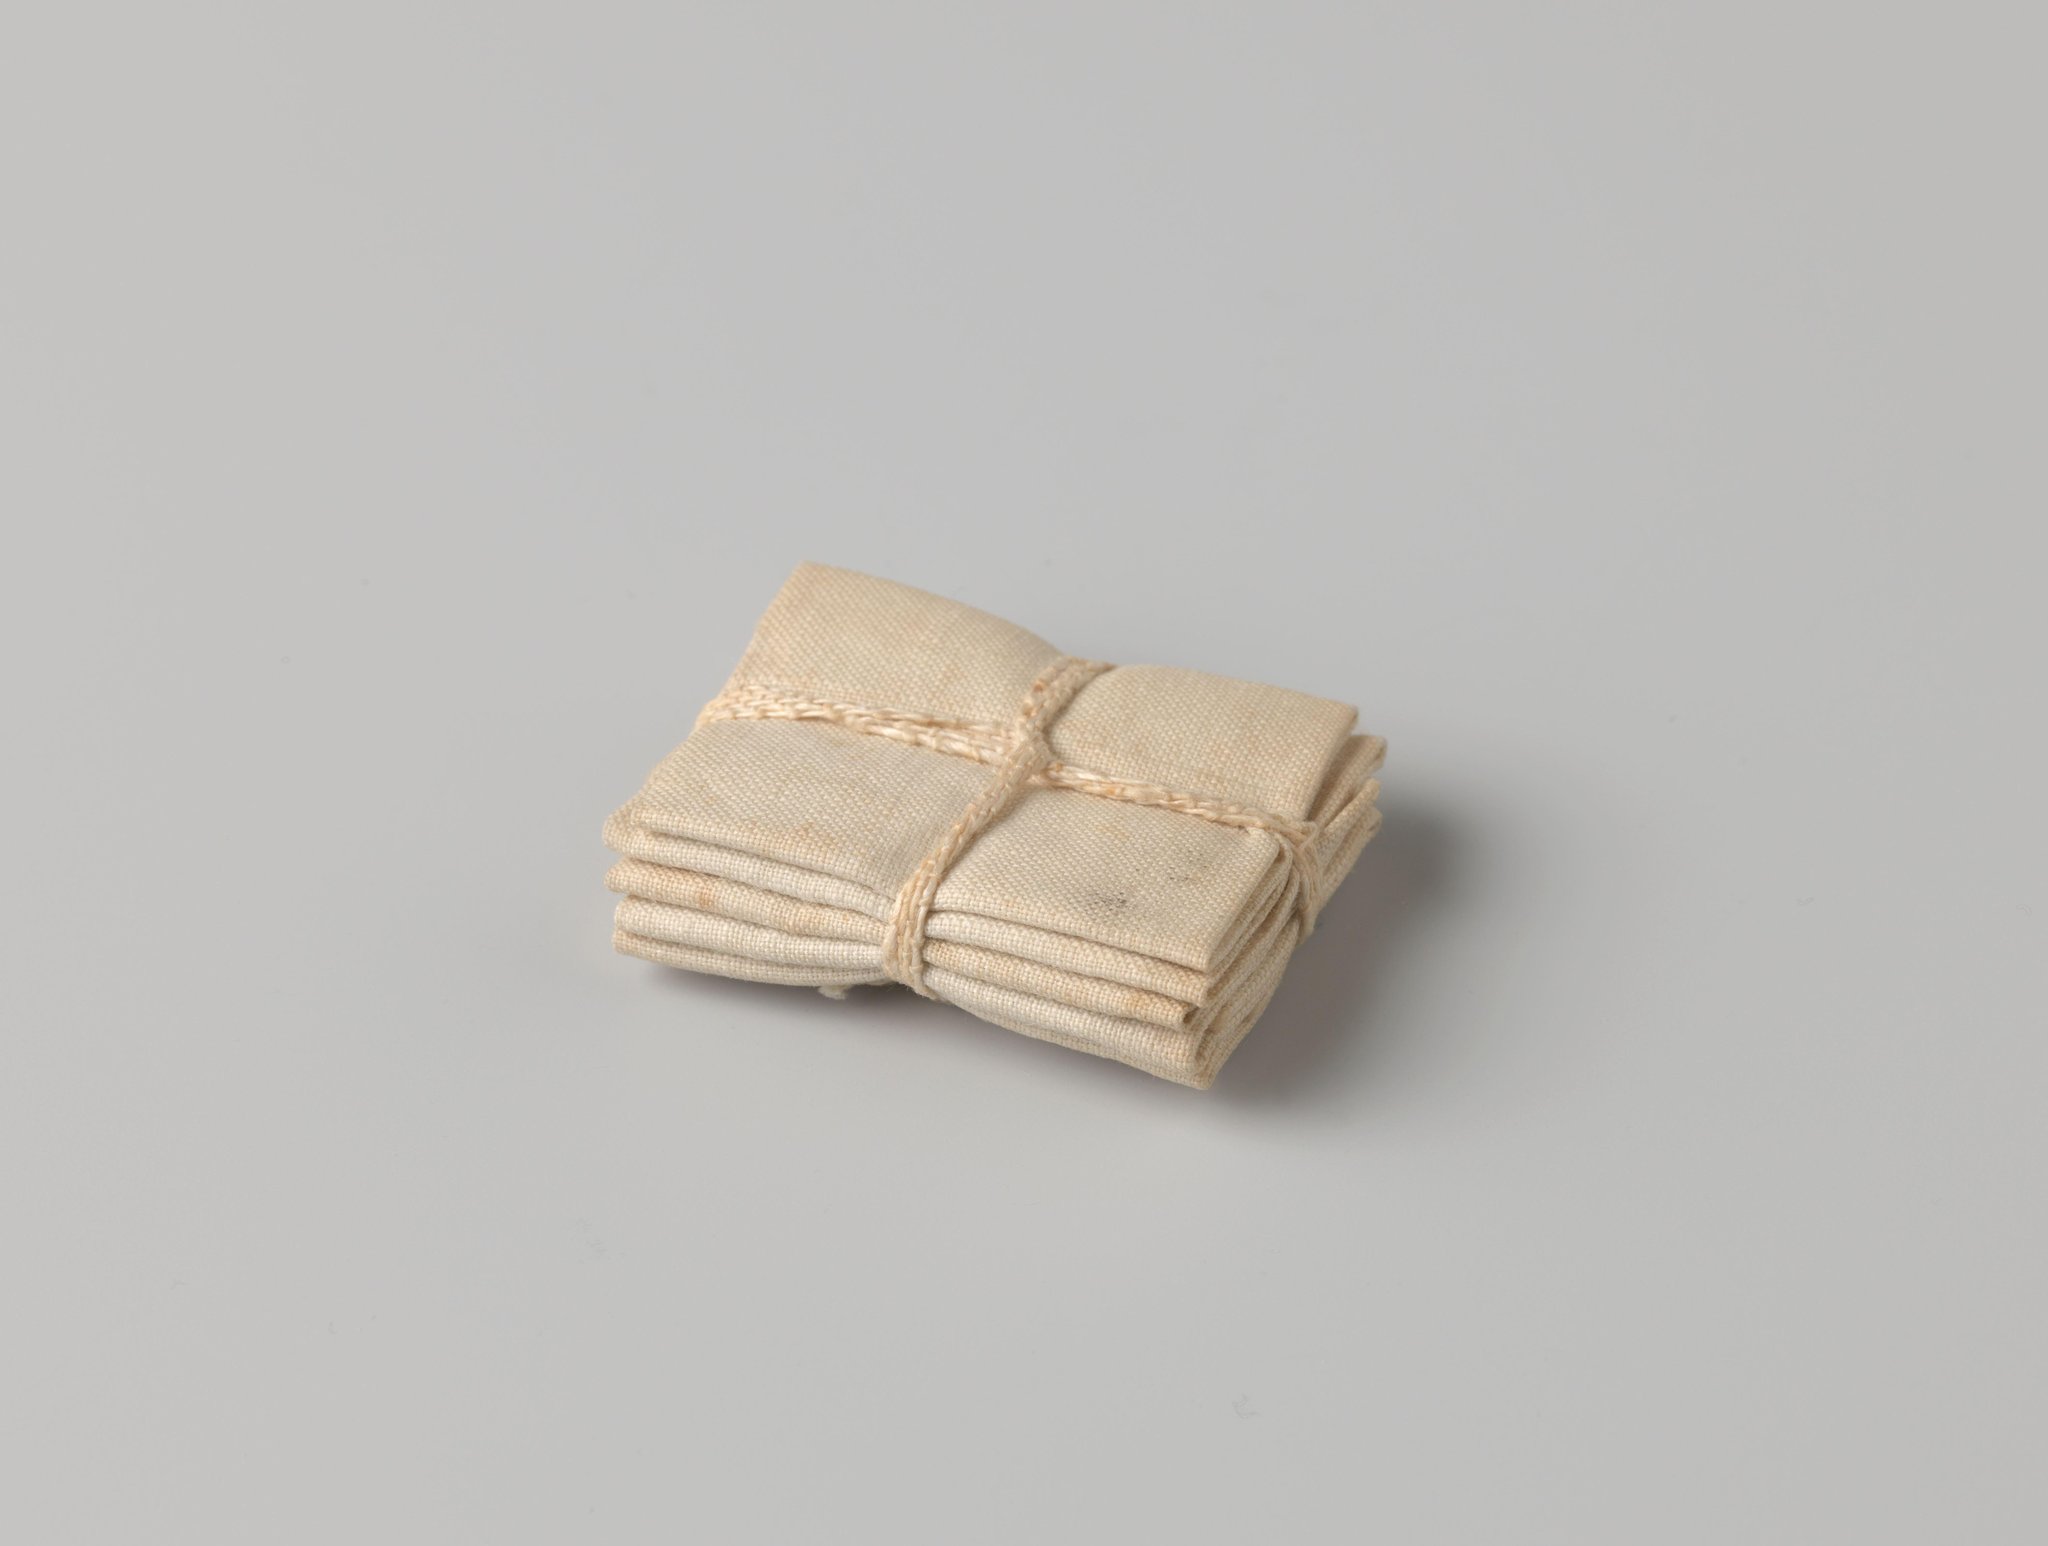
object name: miniature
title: Stapel van vijf lappen, samengebonden met band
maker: Anonymous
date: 1750-1800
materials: cotton, linen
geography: netherlands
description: Een stapel van vijf opgevouwen en met linnen band samengebonden lappen van katoen.